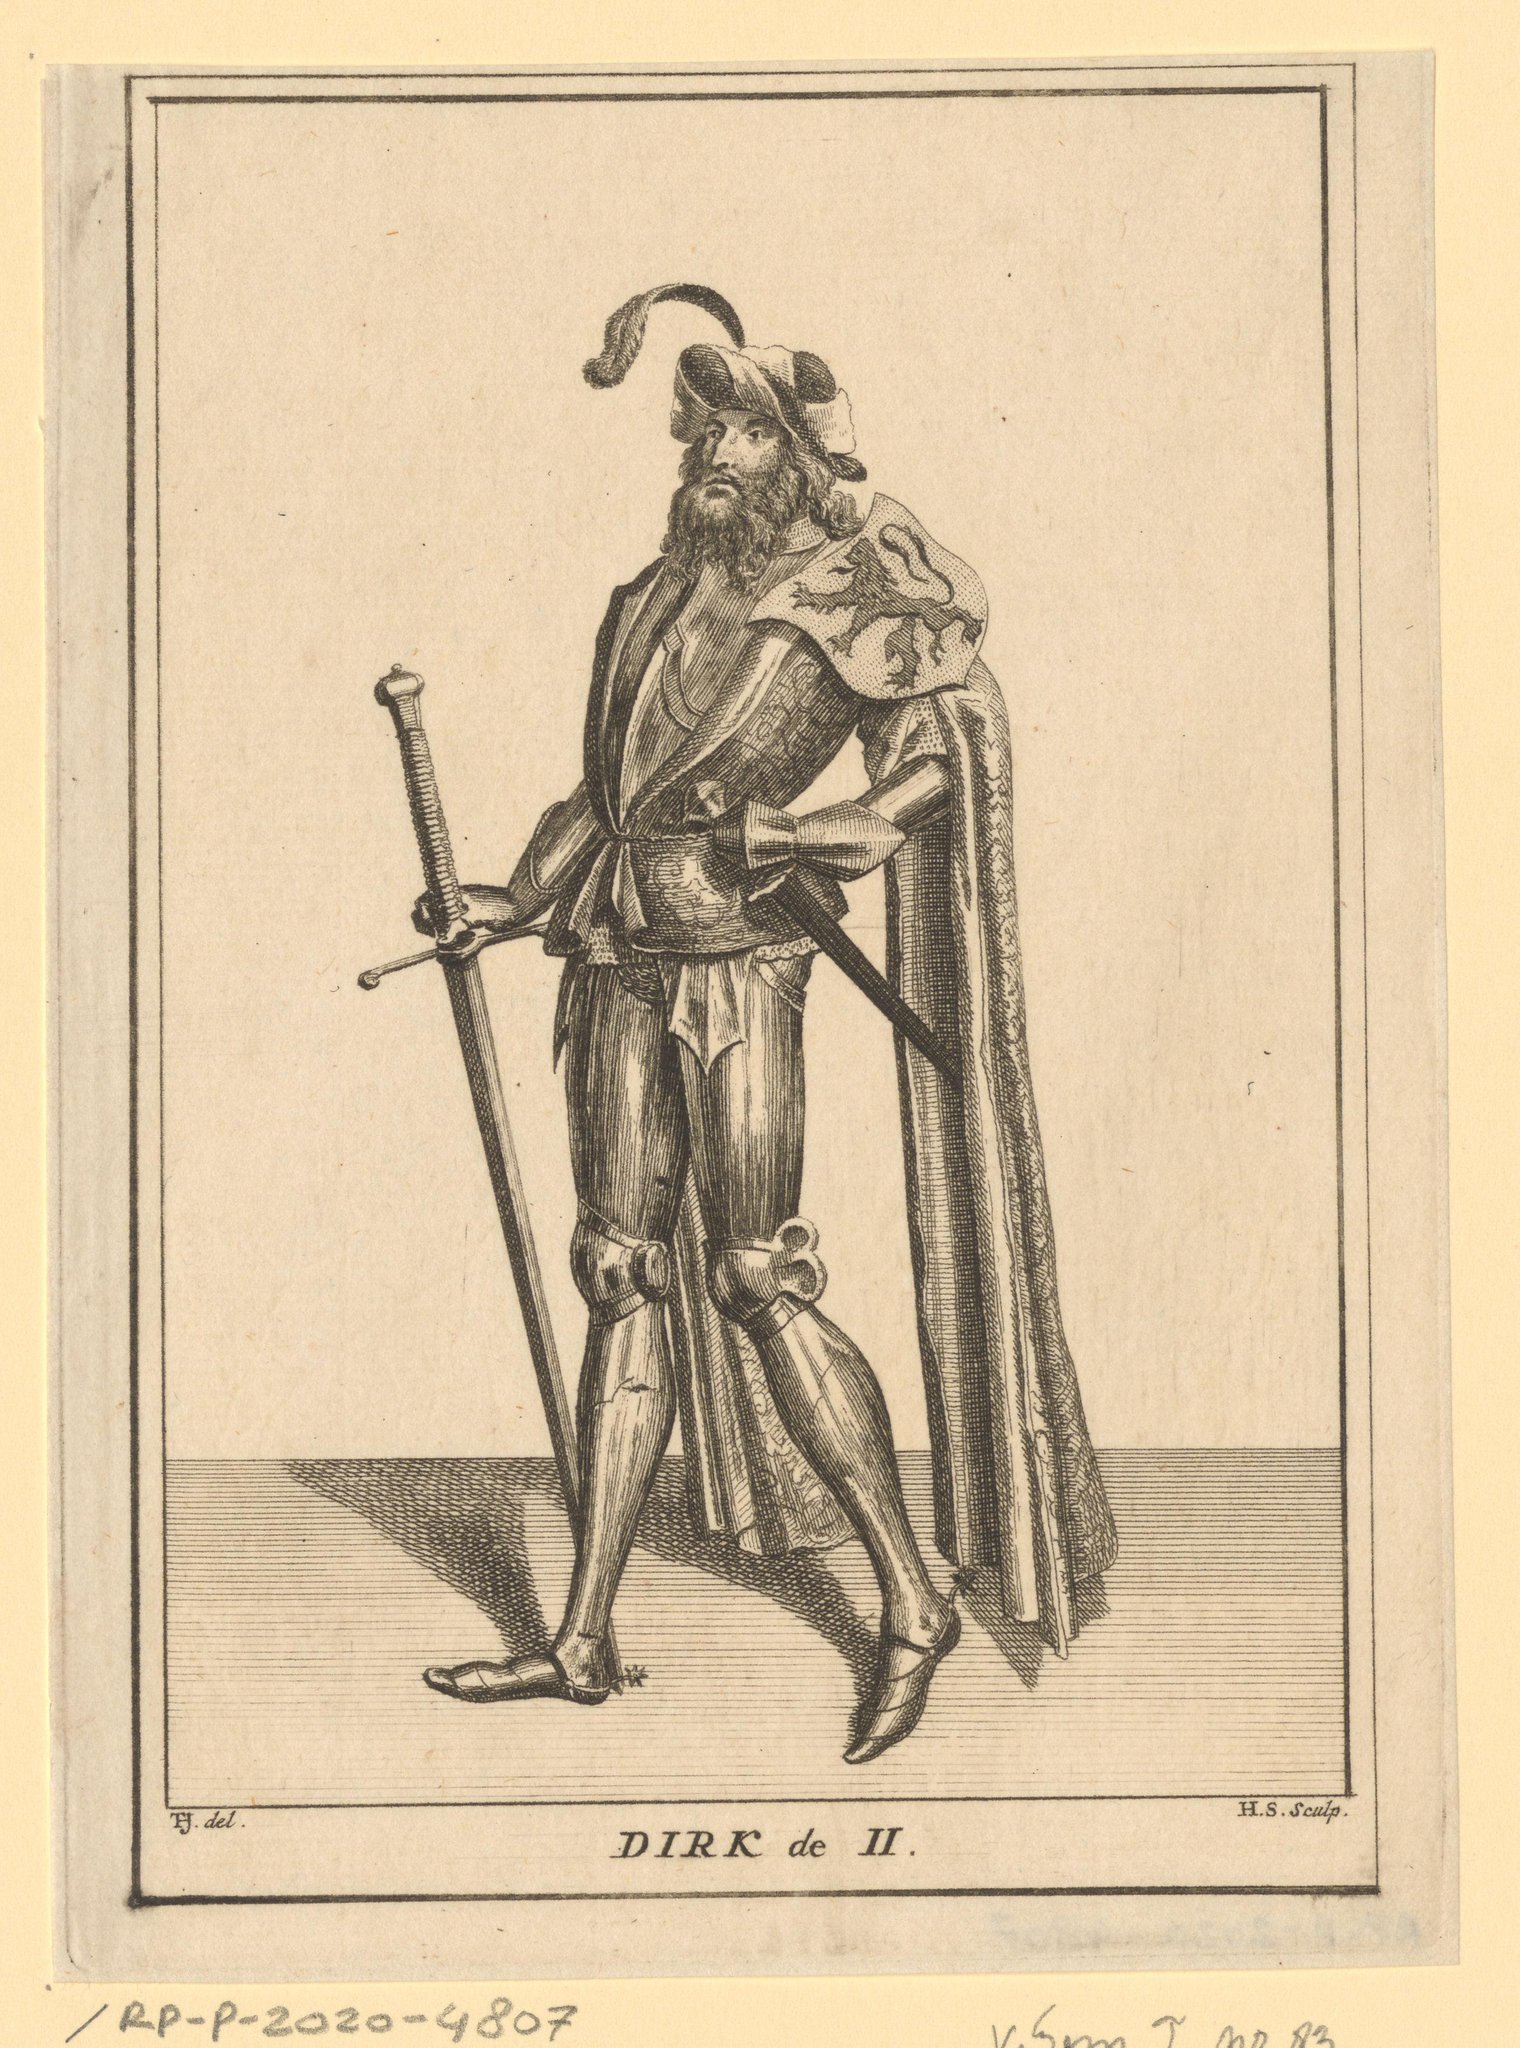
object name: print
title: Portret van Dirk II, graaf van Holland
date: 1745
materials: paper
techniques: etching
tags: historical persons, hacking and thrusting weapons: sword, ruler, sovereign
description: Prent waarschijnlijk uit: Langendyk, Pieter. De graaven van Holland, in jaardichten beschreven. Haarlem: Jan Bosch, 1745, dl. 1.